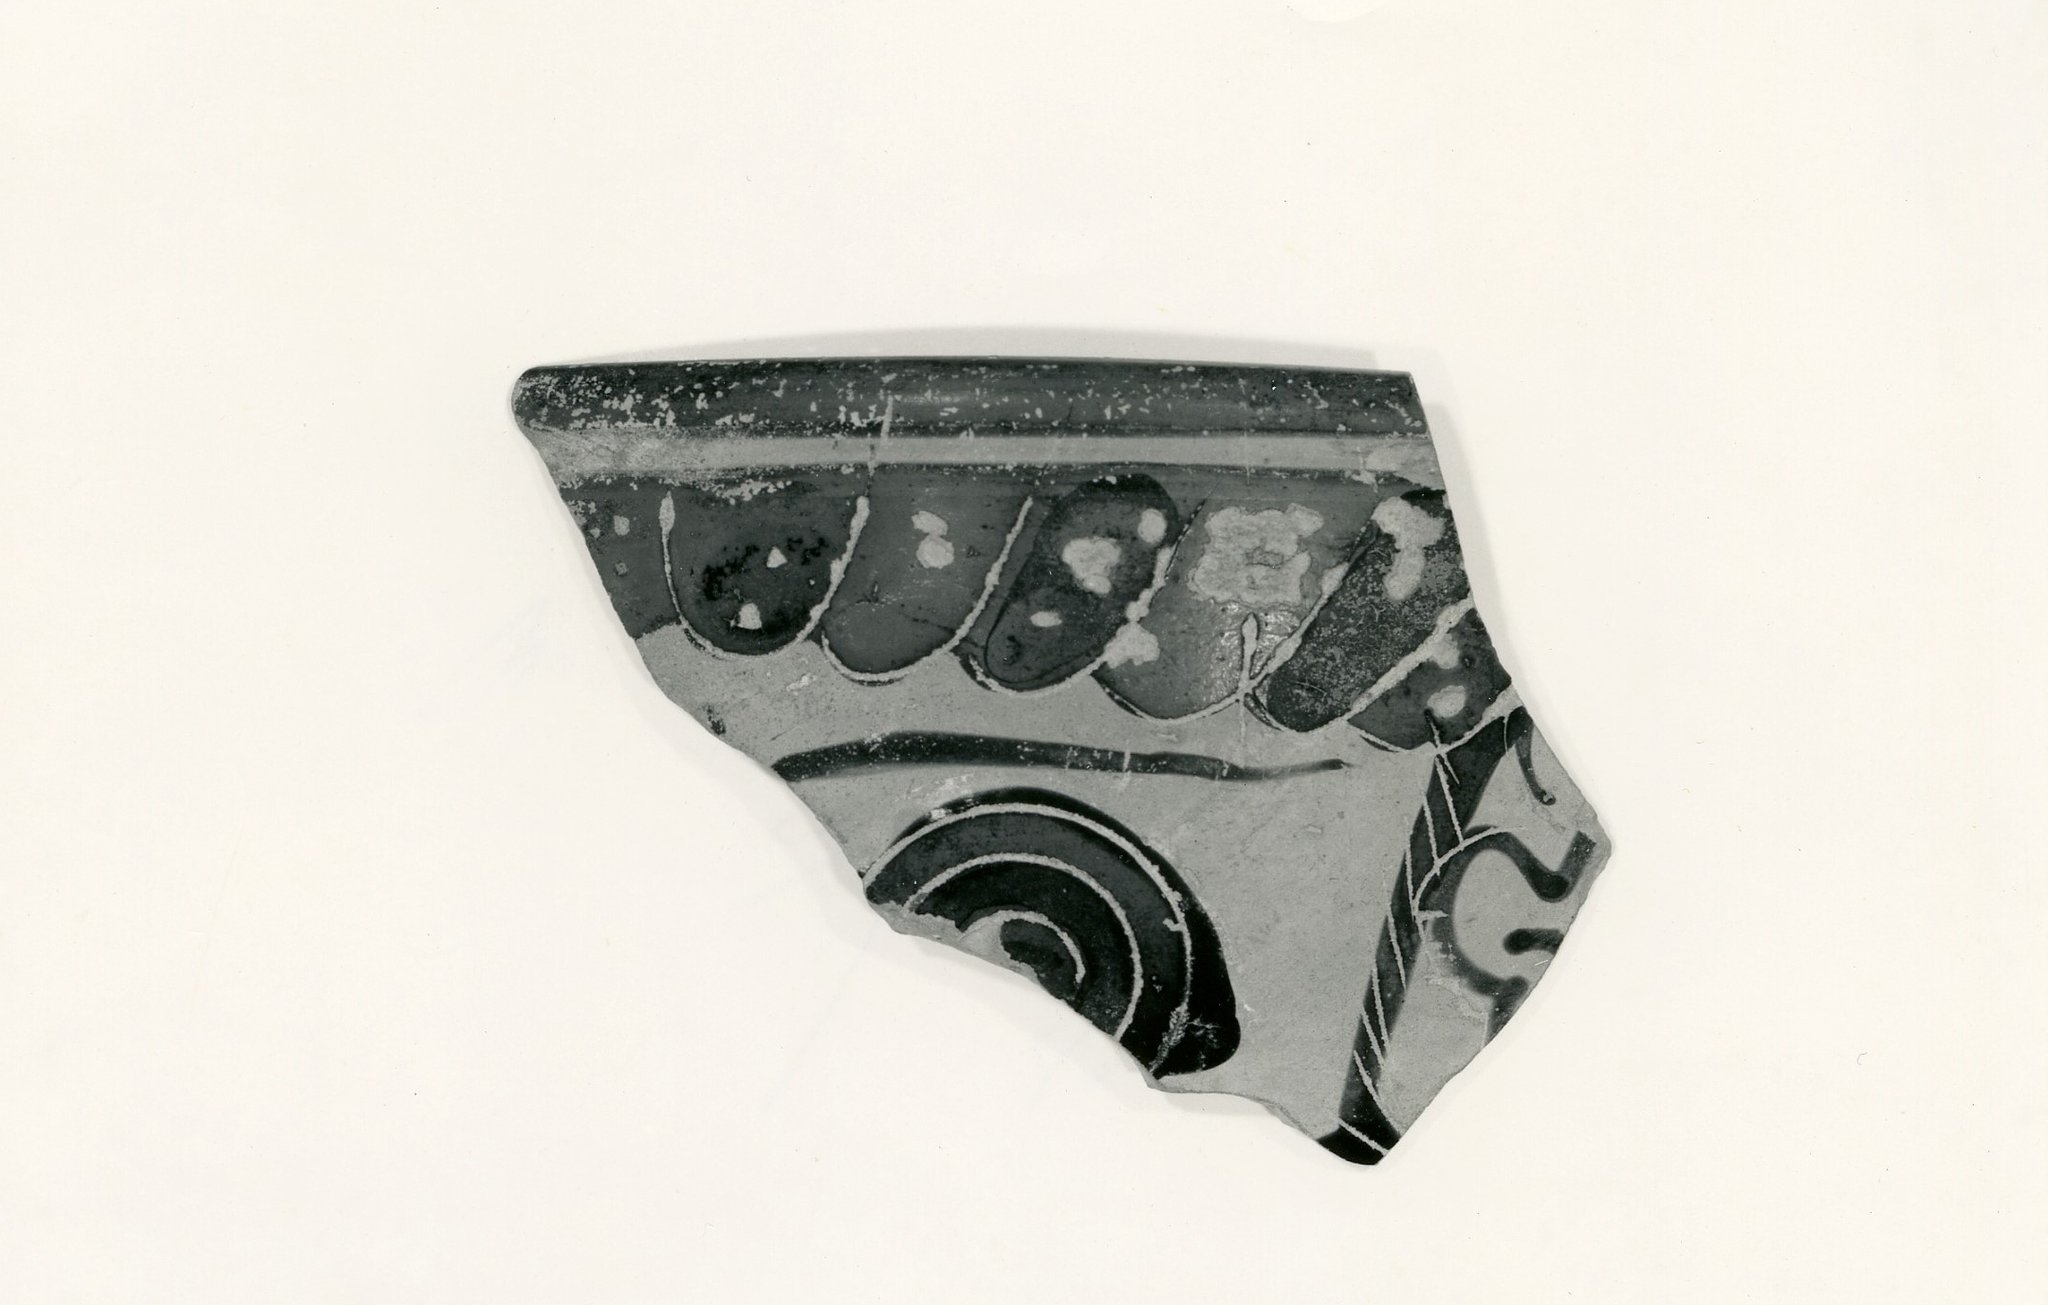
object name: skyphos fragment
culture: greek, attic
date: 600-501 BCE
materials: terracotta